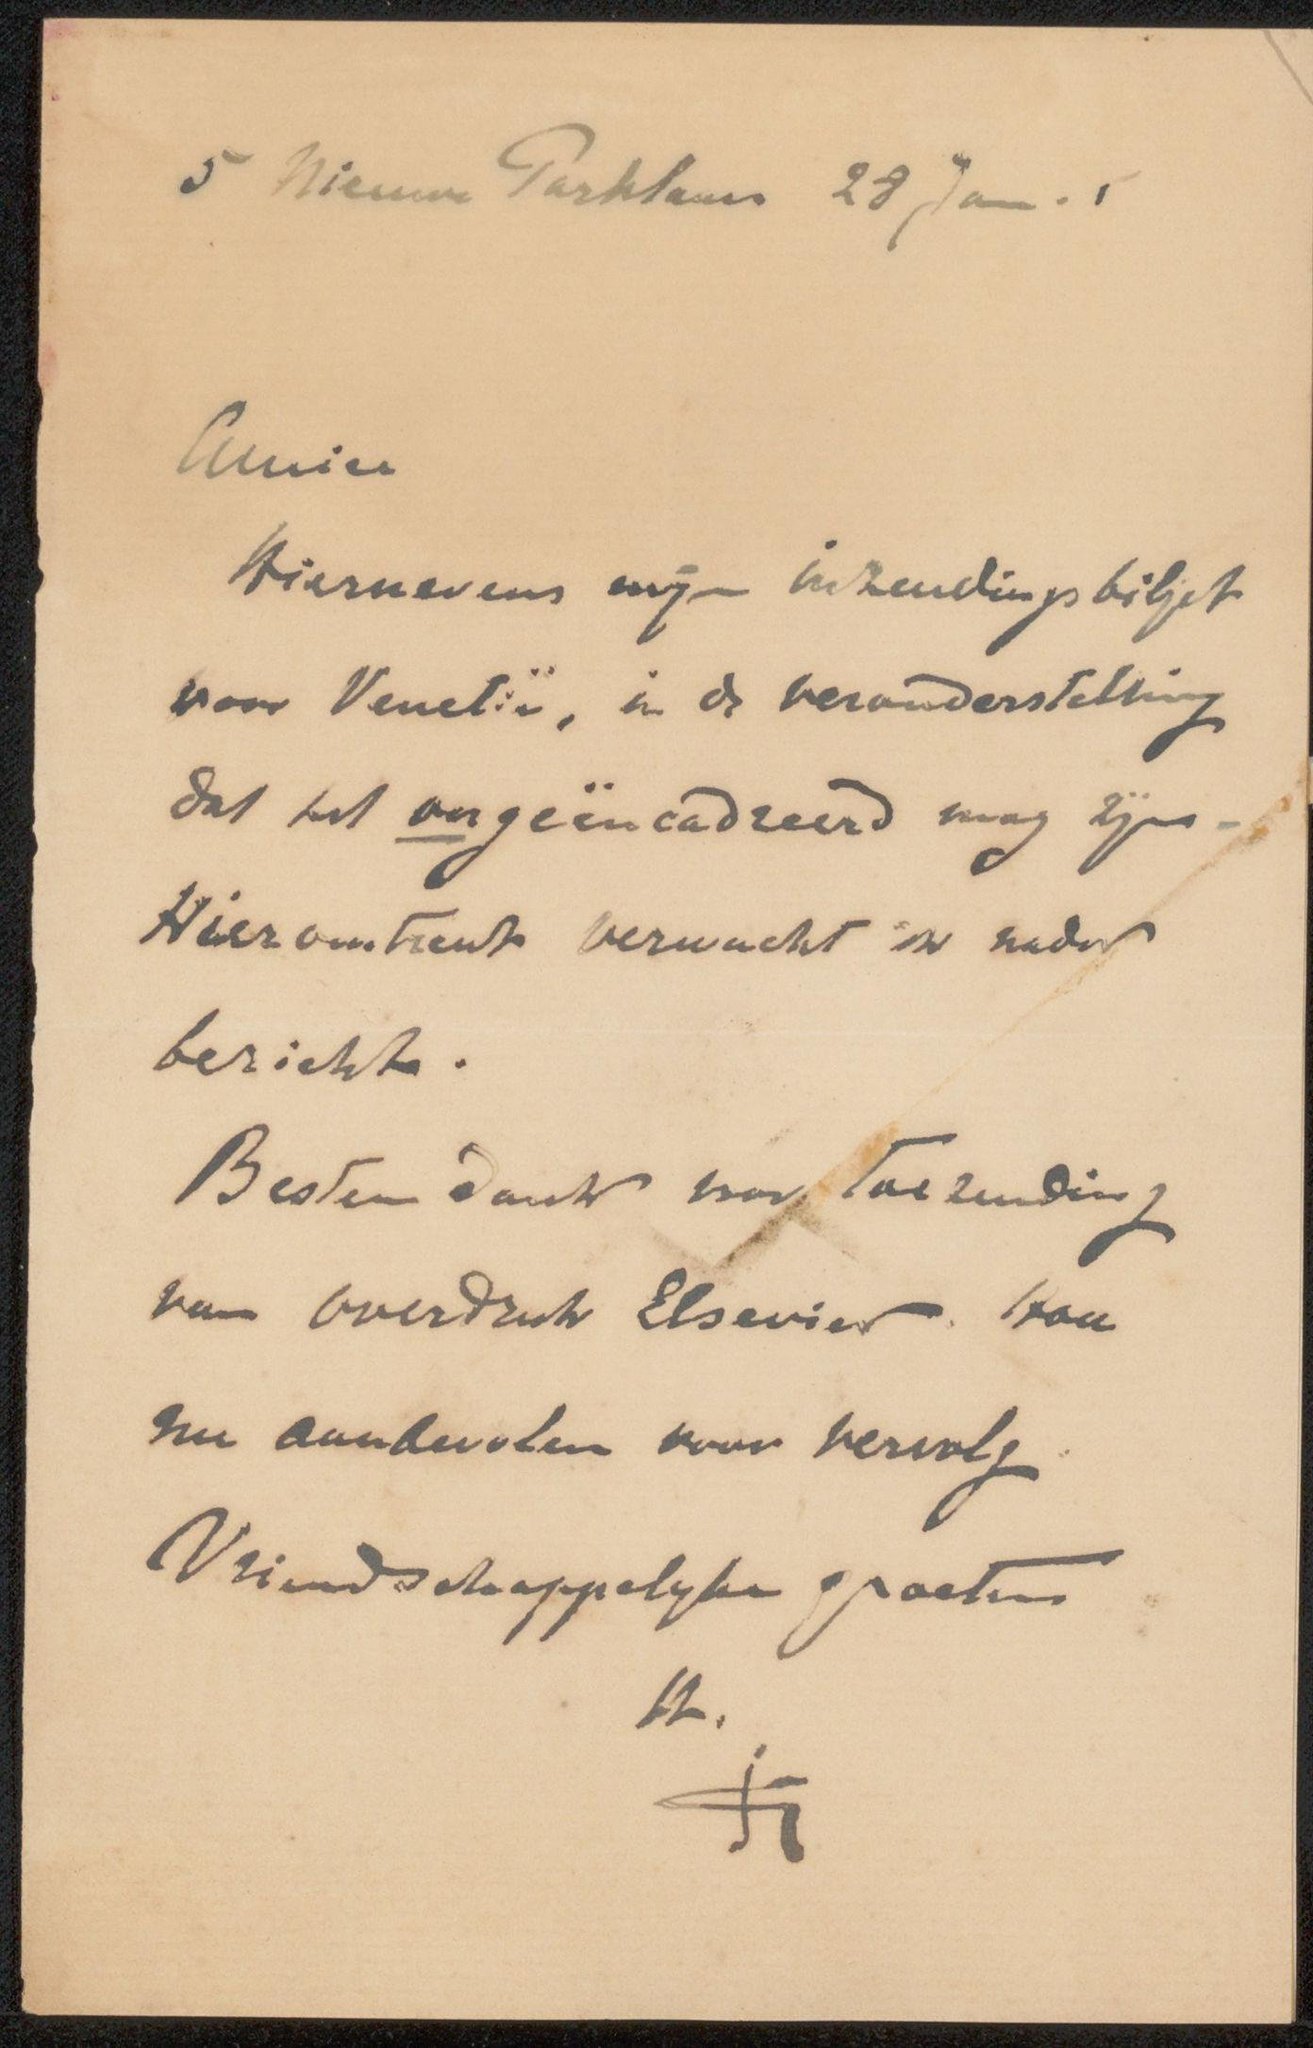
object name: letter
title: Brief aan Philip Zilcken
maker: carel nicolaas storm van s-gravesande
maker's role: draughtsman, print maker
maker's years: 1841-1924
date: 1905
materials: ink, paper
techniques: pen, writing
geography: the hague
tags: painter, philip zilcken, exhibition ~ art, venice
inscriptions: watermark, collector's mark: ‘RPK’